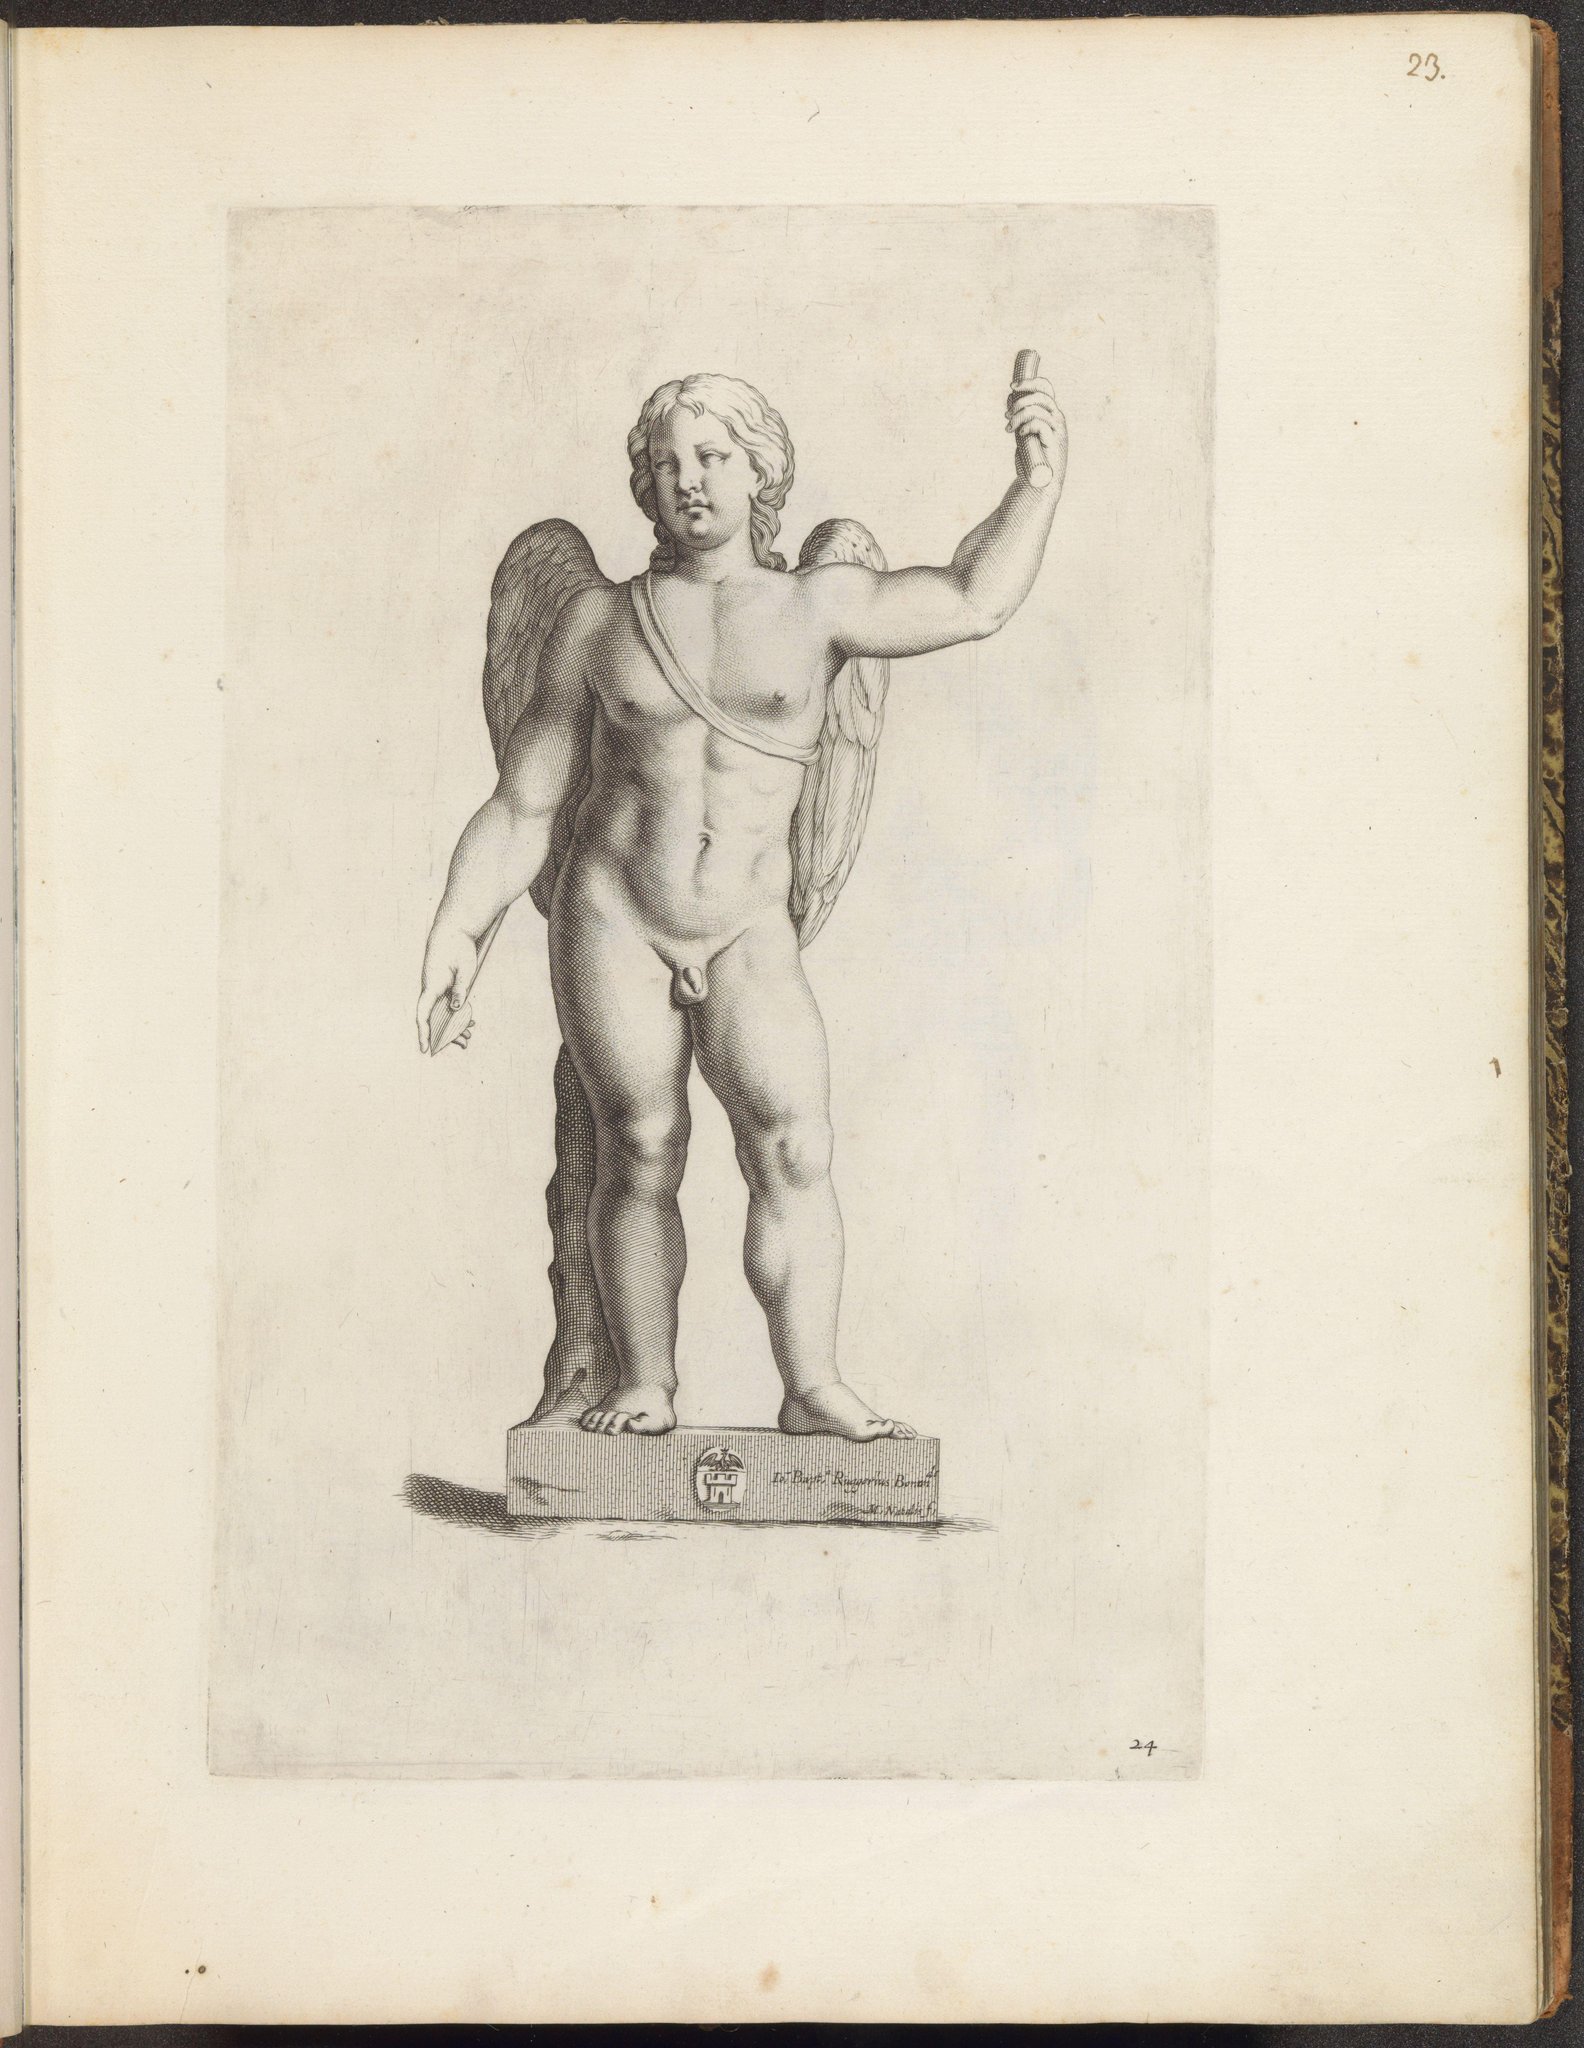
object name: print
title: Galleria Giustiniana del Marchese Vincenzo Giustiniani I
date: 1636-1647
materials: paper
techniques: engraving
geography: rome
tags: attributes of cupid: arrow(s), piece of sculpture, reproduction of a piece of sculpture, (story of) cupid, amor (eros)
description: Standbeeld van gevleugelde Amor, in zijn rechterhand een pijl, in zijn linkerhand een fragment van een boog. Op de basis het wapenschild van Vincenzo Giustiniani. Prent maakt deel uit van een album met een serie prenten naar de sculpturen in de verzameling in de Galleria Giustiniani te Rome.